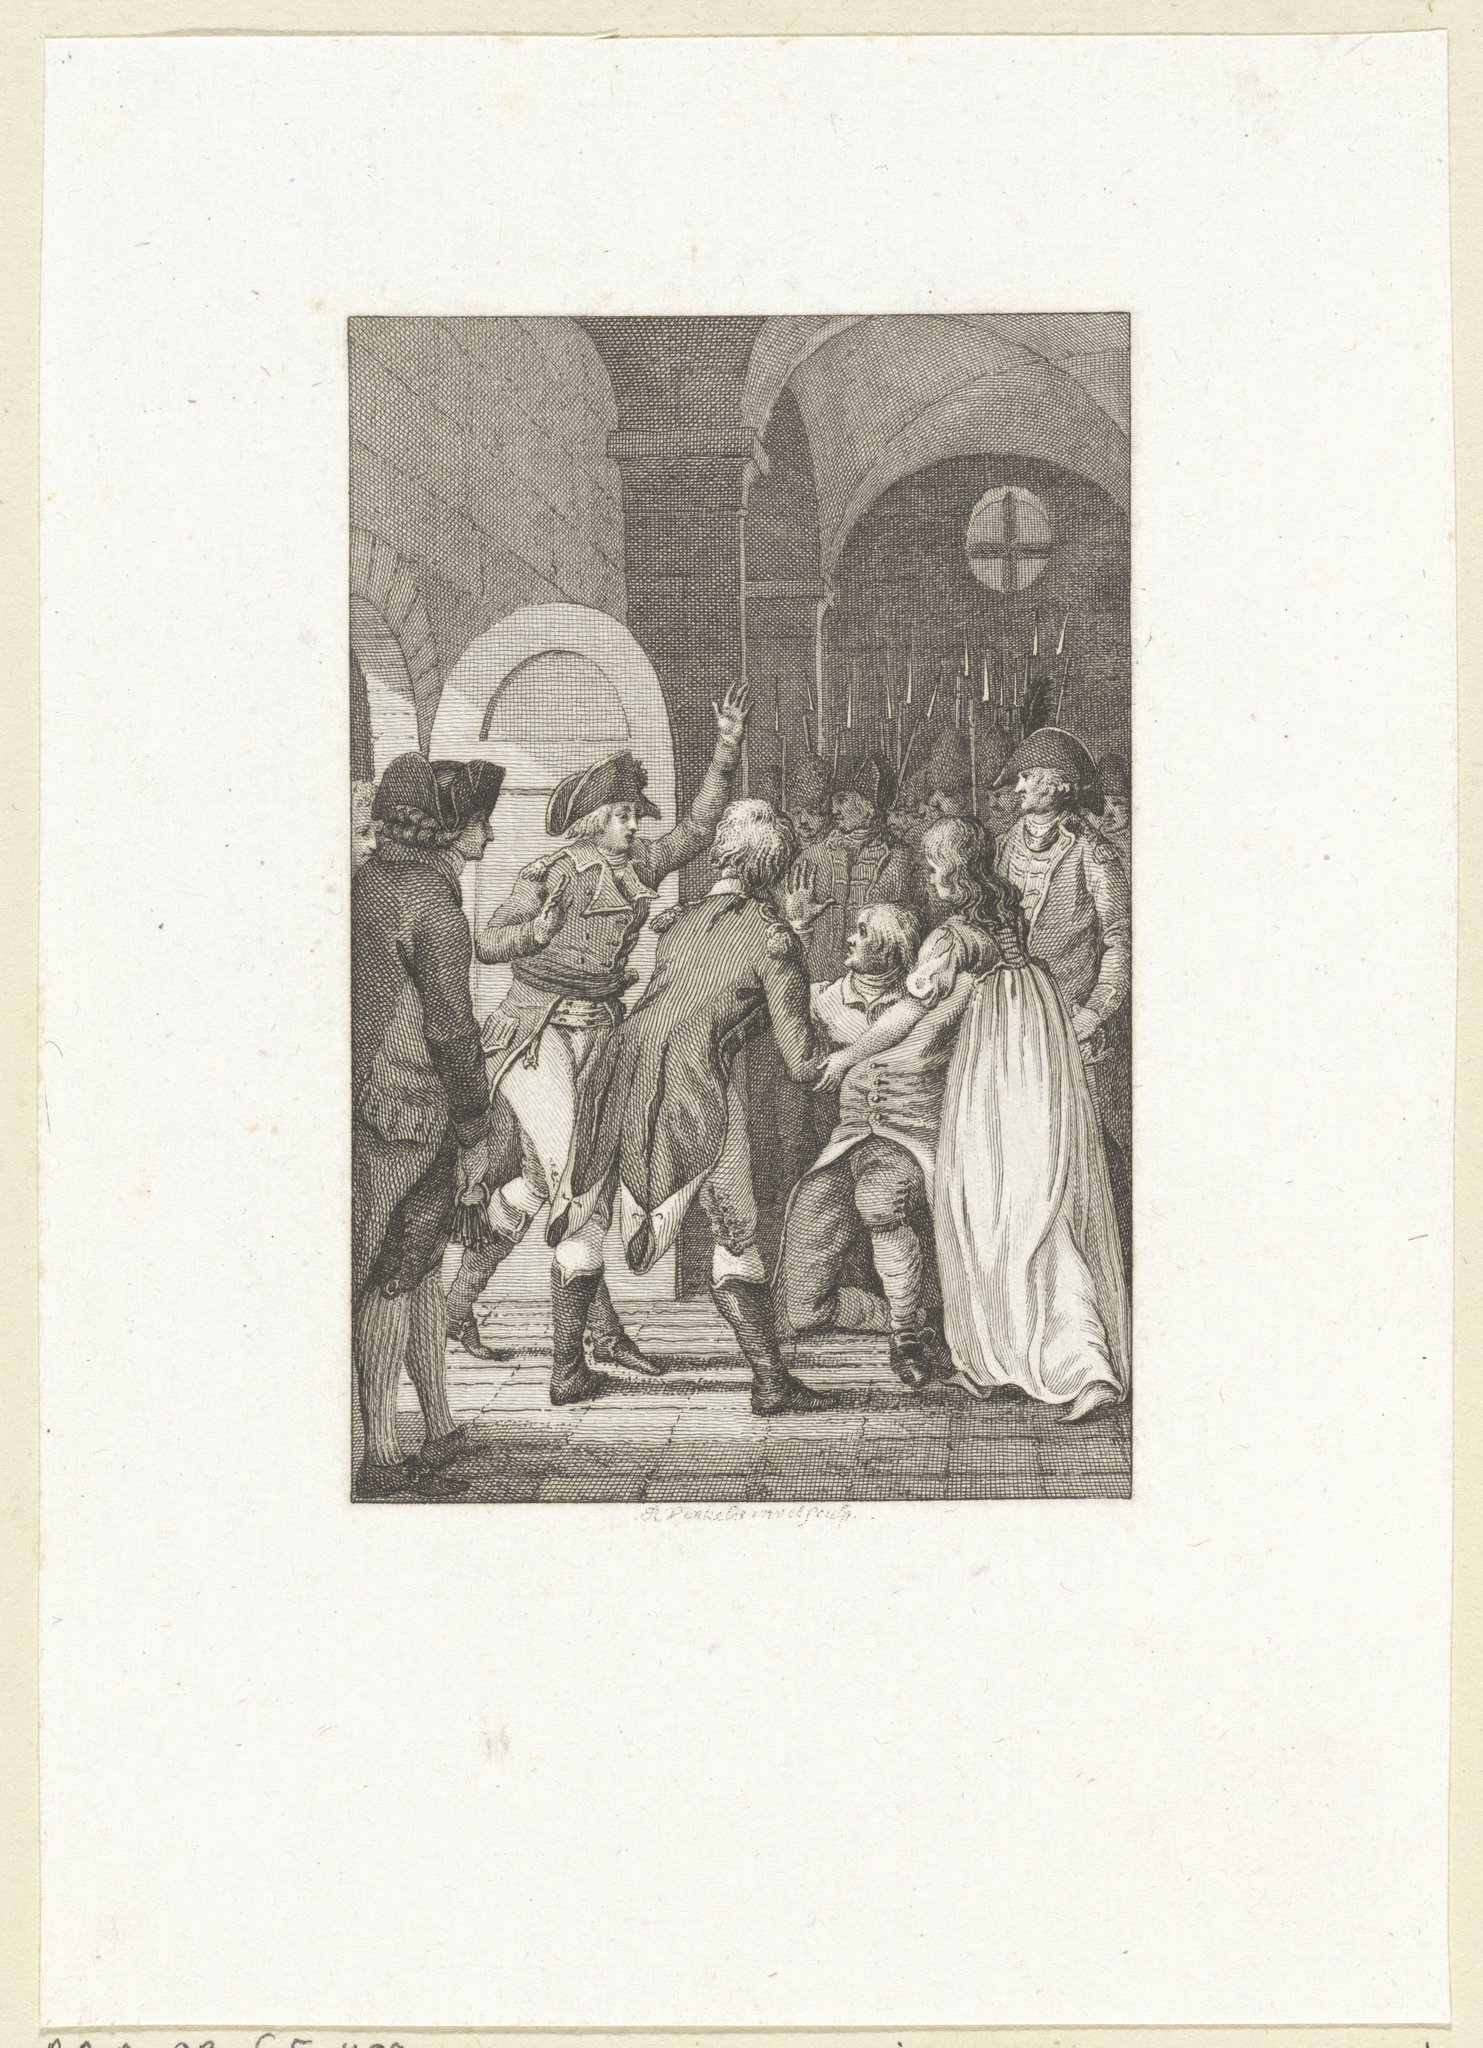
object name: print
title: Geknielde man met een vrouw te midden van soldaten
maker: reinier vinkeles (i)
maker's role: draughtsman, print maker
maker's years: 1741-1816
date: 1800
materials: paper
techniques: engraving, etching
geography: amsterdam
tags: the soldier; the soldier's life, kneeling figure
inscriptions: collector's mark: Lugt 240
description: Proefdruk van een prent die mogelijk ook gebruikt is als illustratie in: Volméranges, Benoît Pelletier de. Natuur en pligt, of De zoon, rechter over zijnen vader. Amsterdam: Gerrit Warnars, 1800.